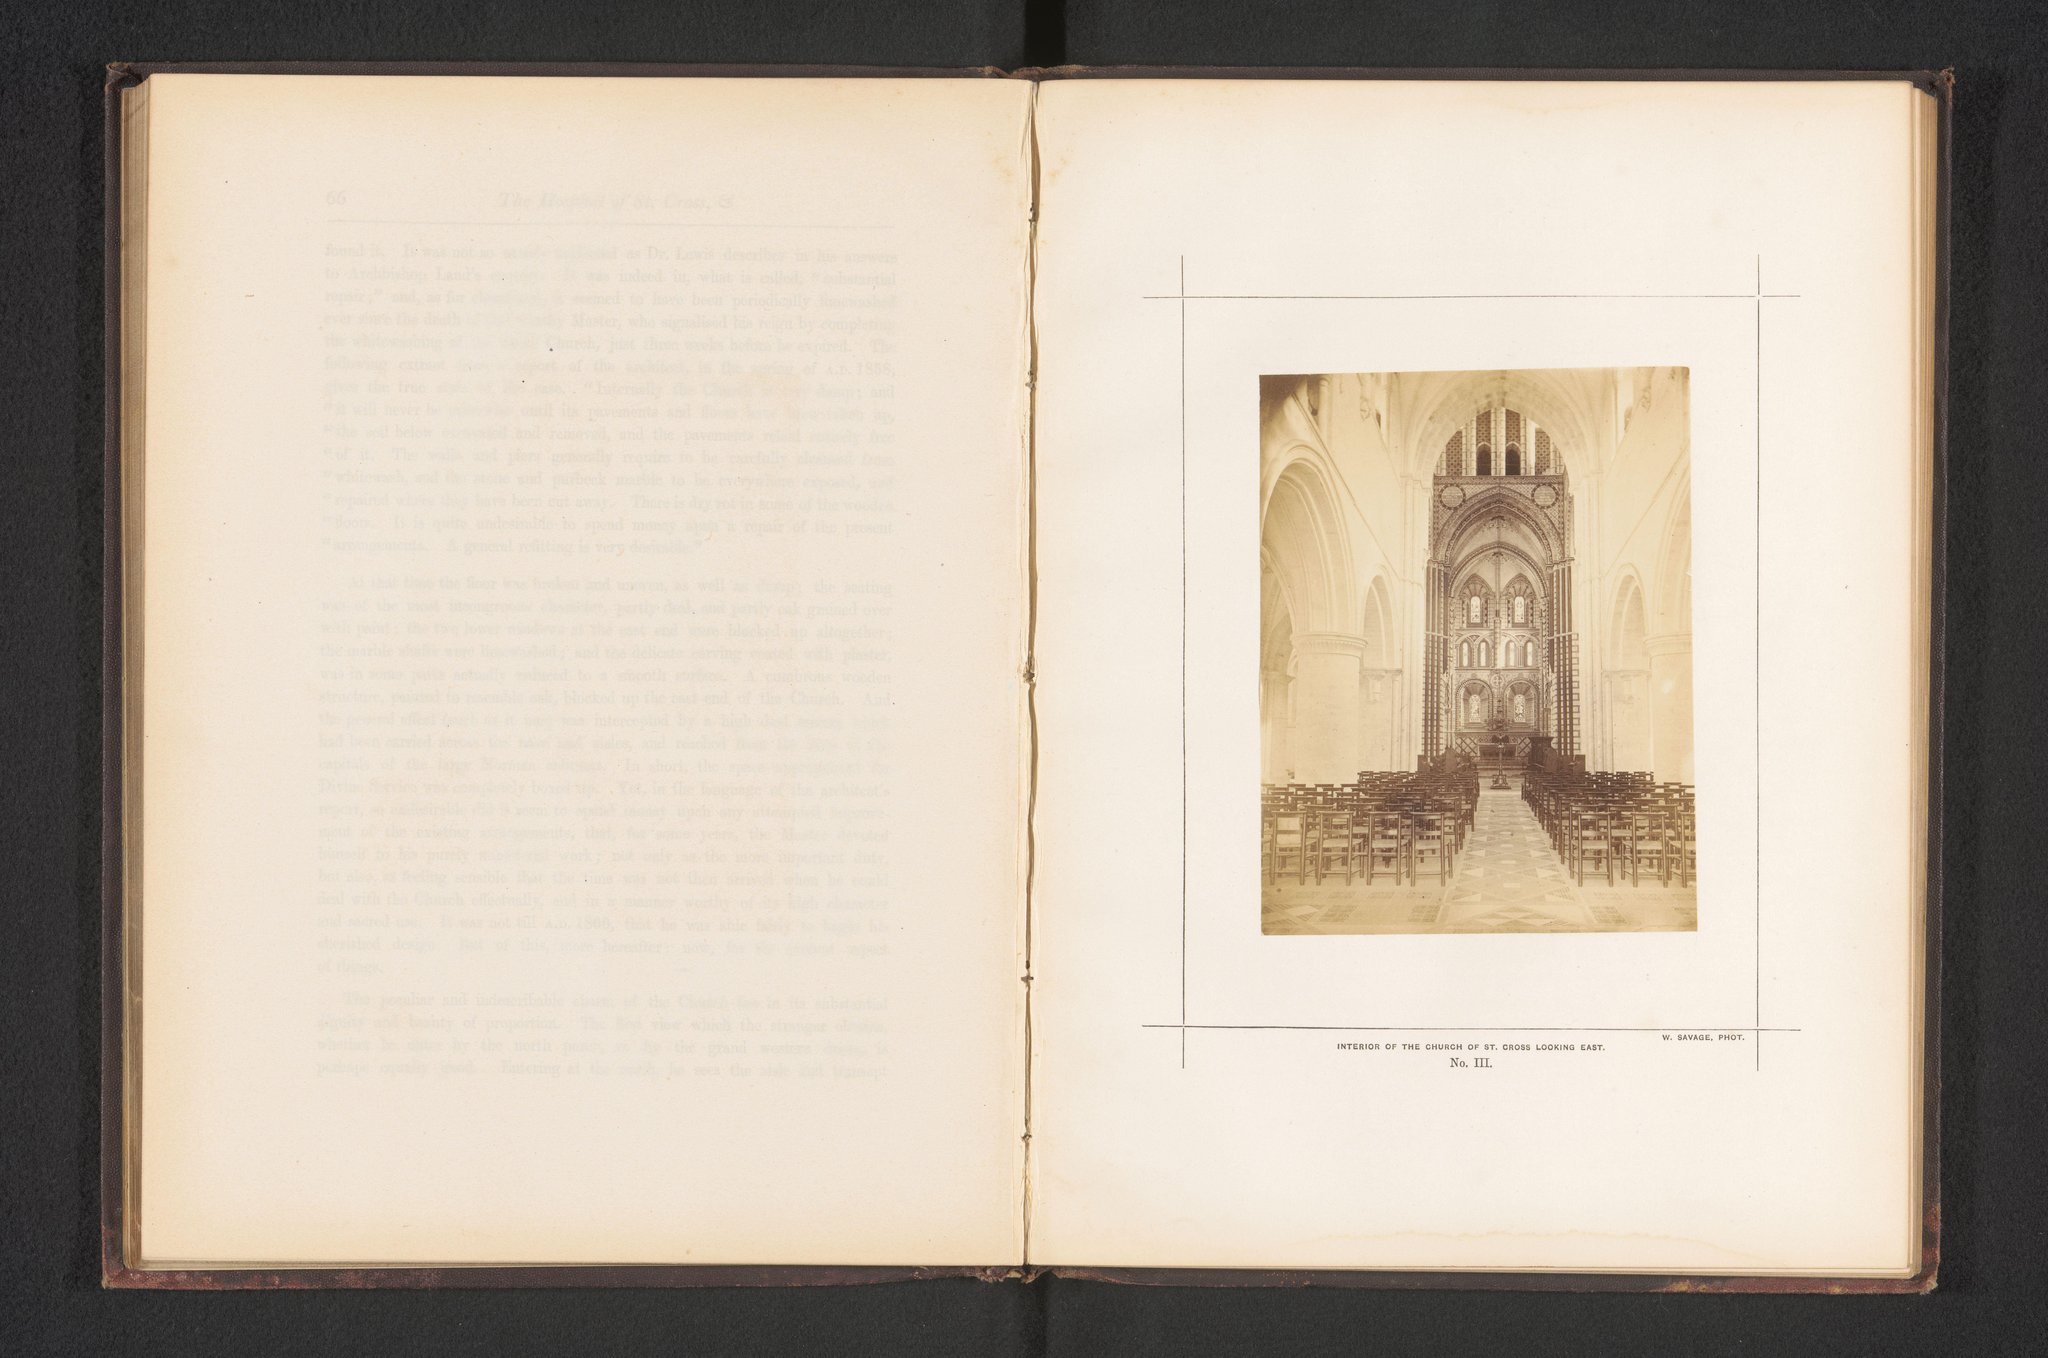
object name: page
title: Interior of the Church of St. Cross looking East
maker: william savage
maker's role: fotograaf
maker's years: 1817-1887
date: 1863-1868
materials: photographic support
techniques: albumen print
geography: winchester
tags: interior of church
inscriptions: inscription: ‘No. III’